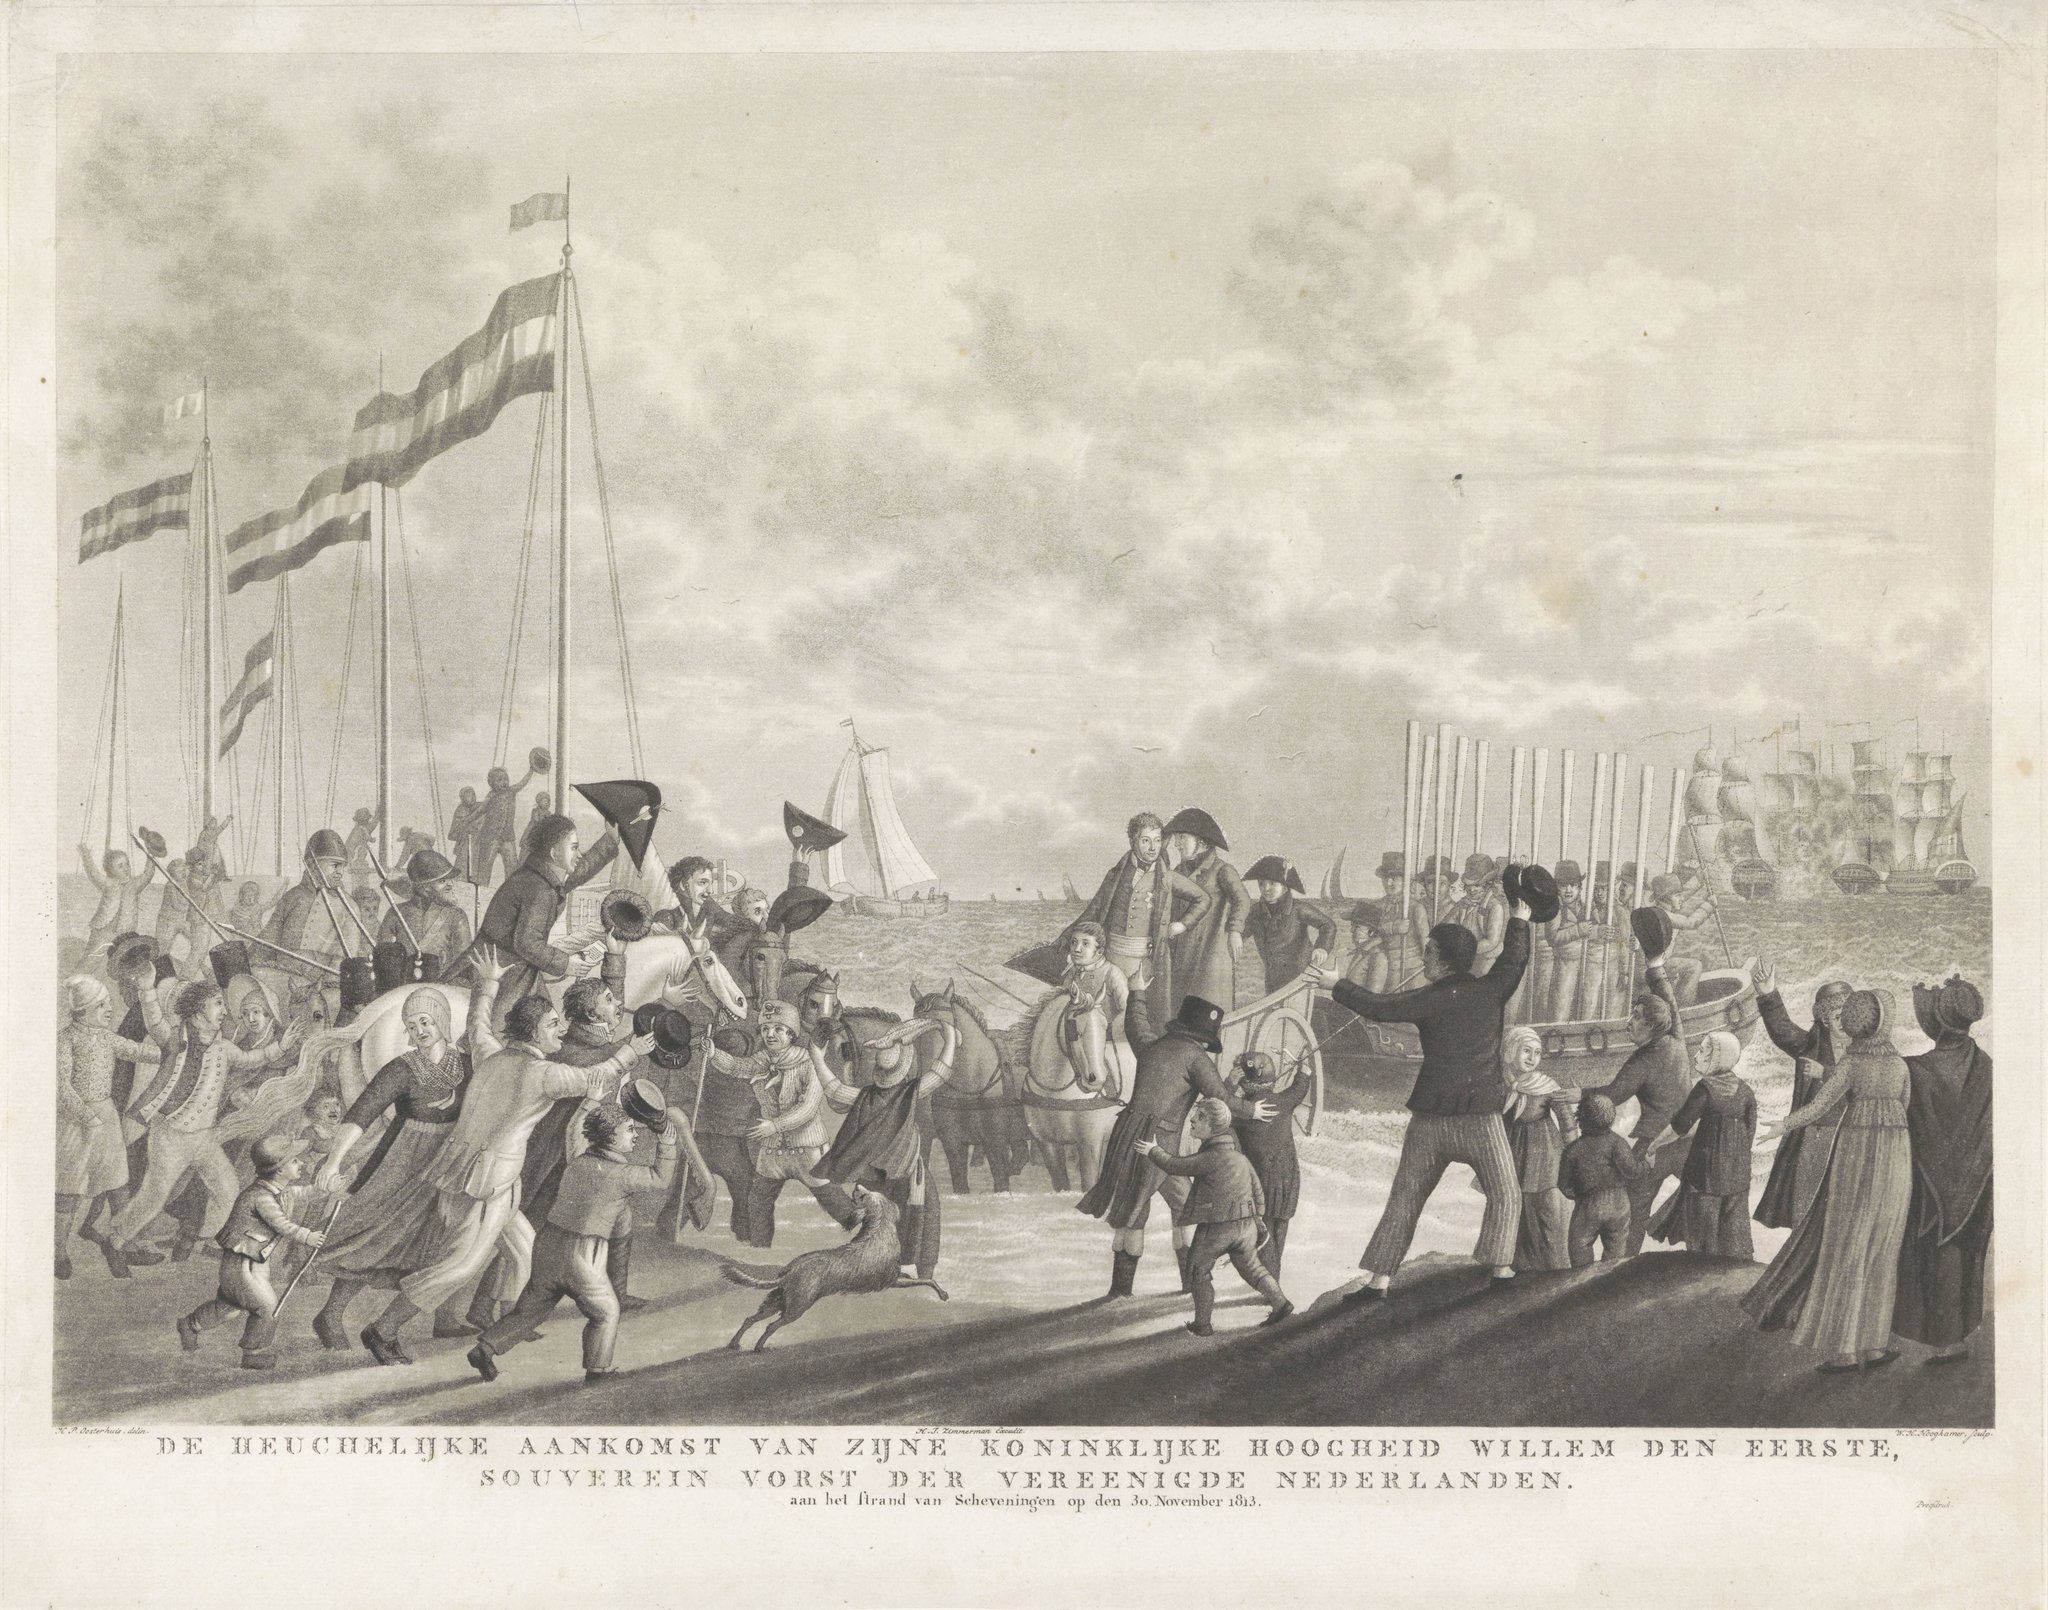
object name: print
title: Aankomst van de prins van Oranje te Scheveningen, 1813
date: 1813-1814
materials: paper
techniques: aquatint, etching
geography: netherlands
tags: the hague, berlin, william i of the netherlands, being welcomed ~ travelling, homage to a ruler, landing of william frederick i (1813)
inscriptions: collector's mark: Lugt 2228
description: De aankomst van prins Willem Frederik als souverein vorst op het strand van Scheveningen op 30 november 1813.